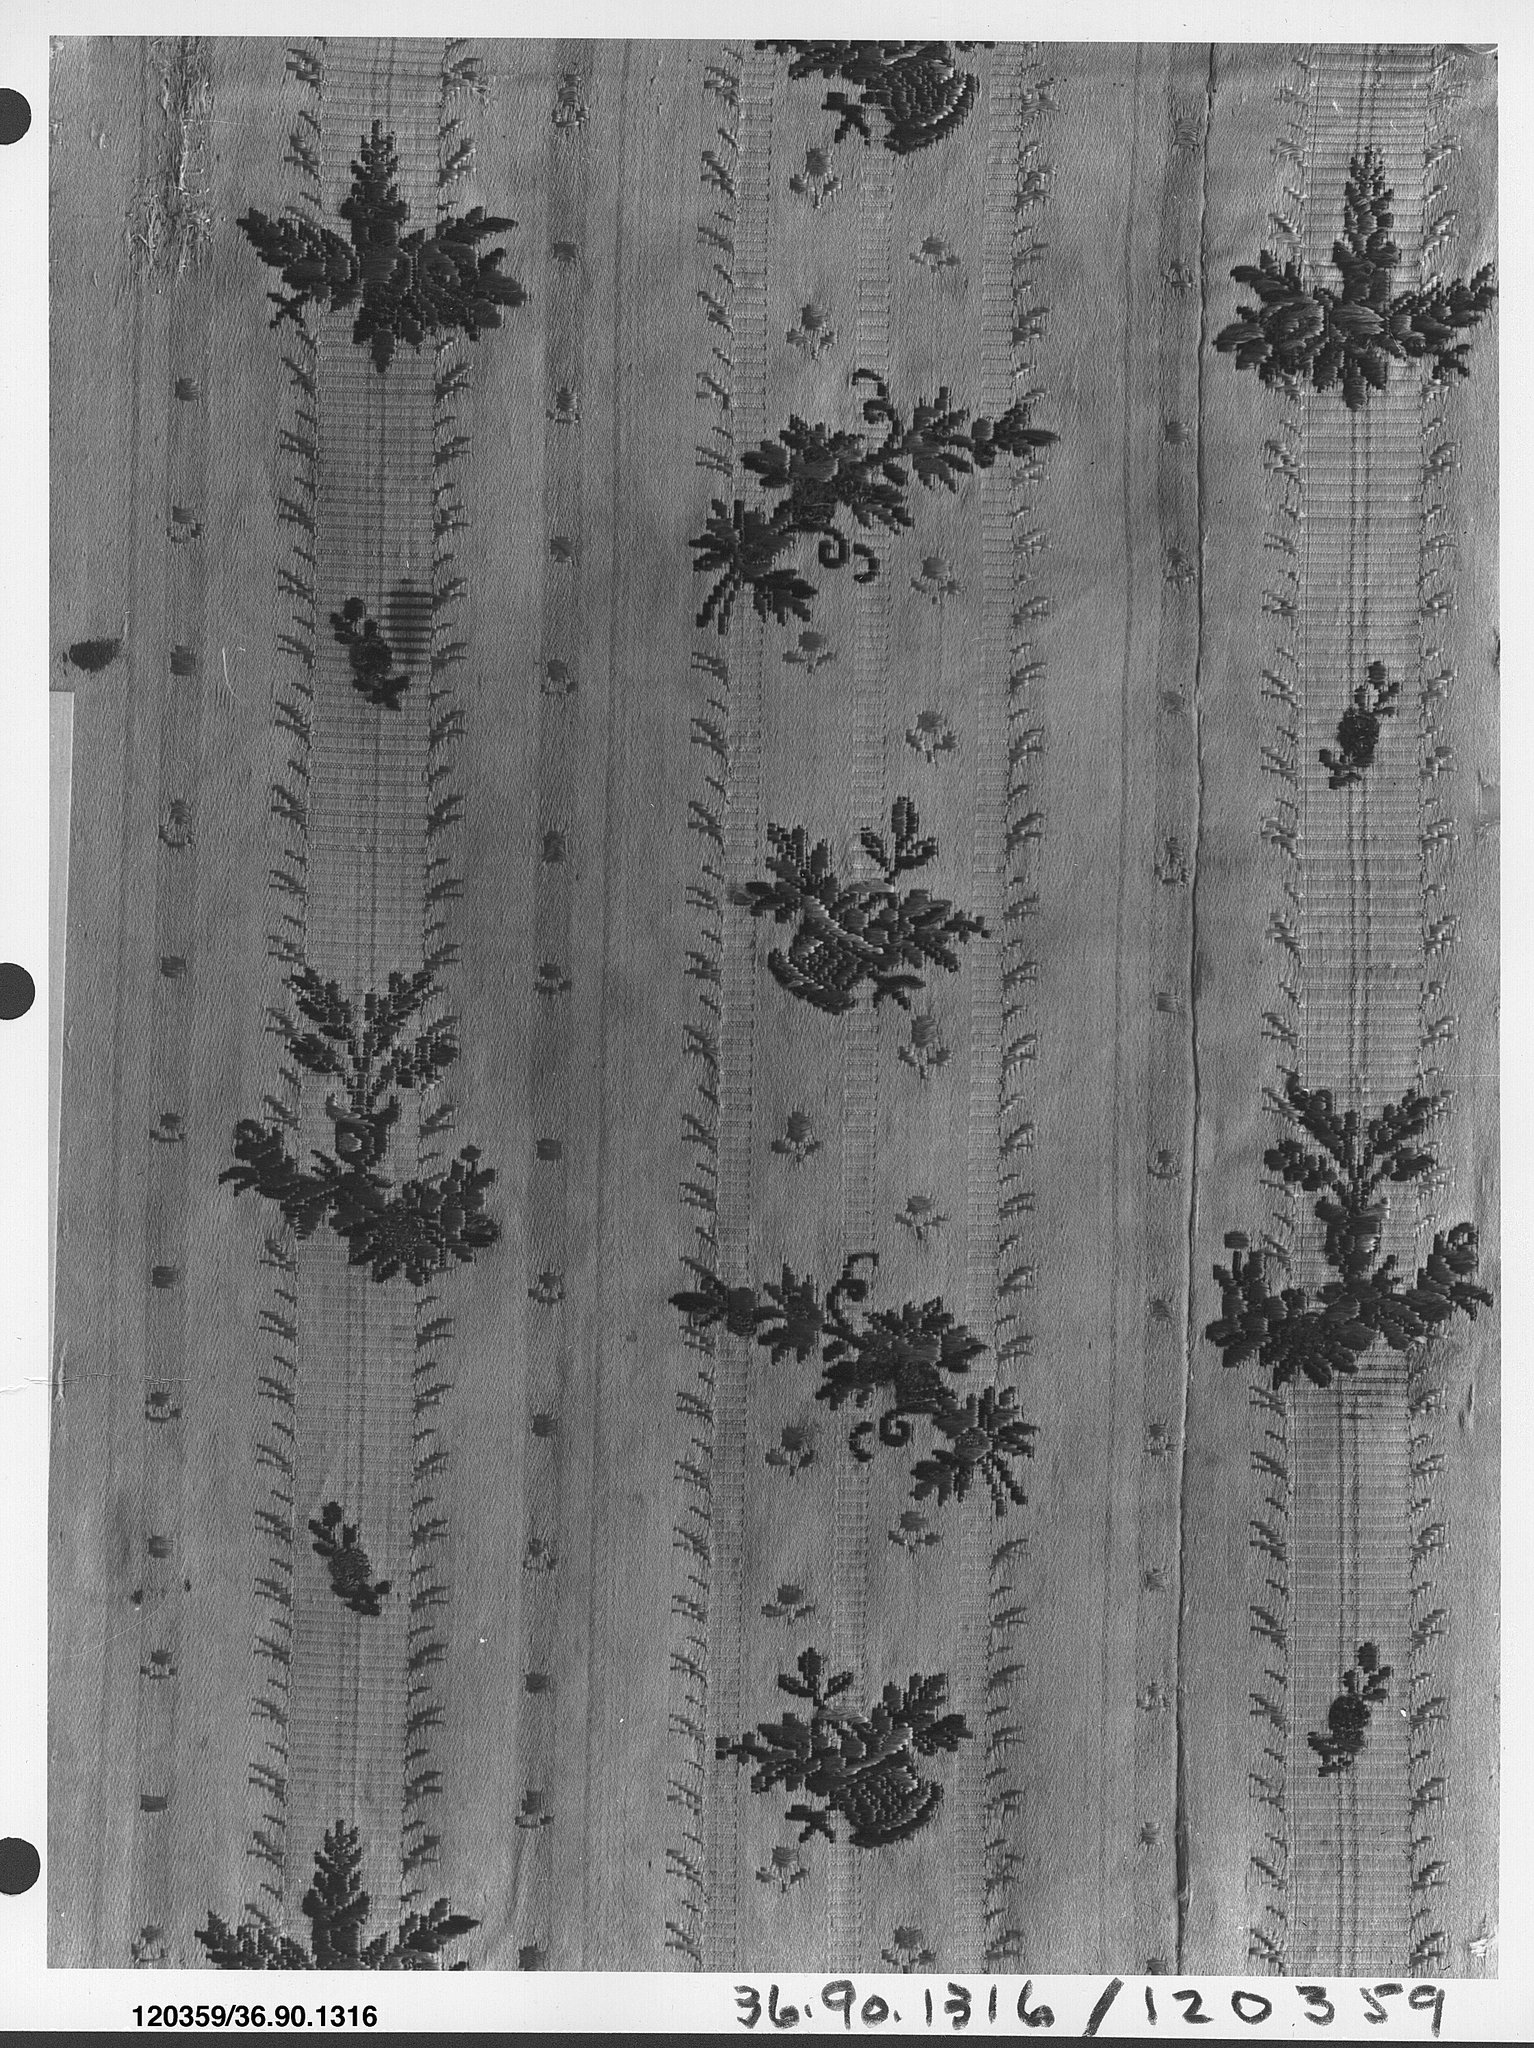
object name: piece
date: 1701-1800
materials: silk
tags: leaves